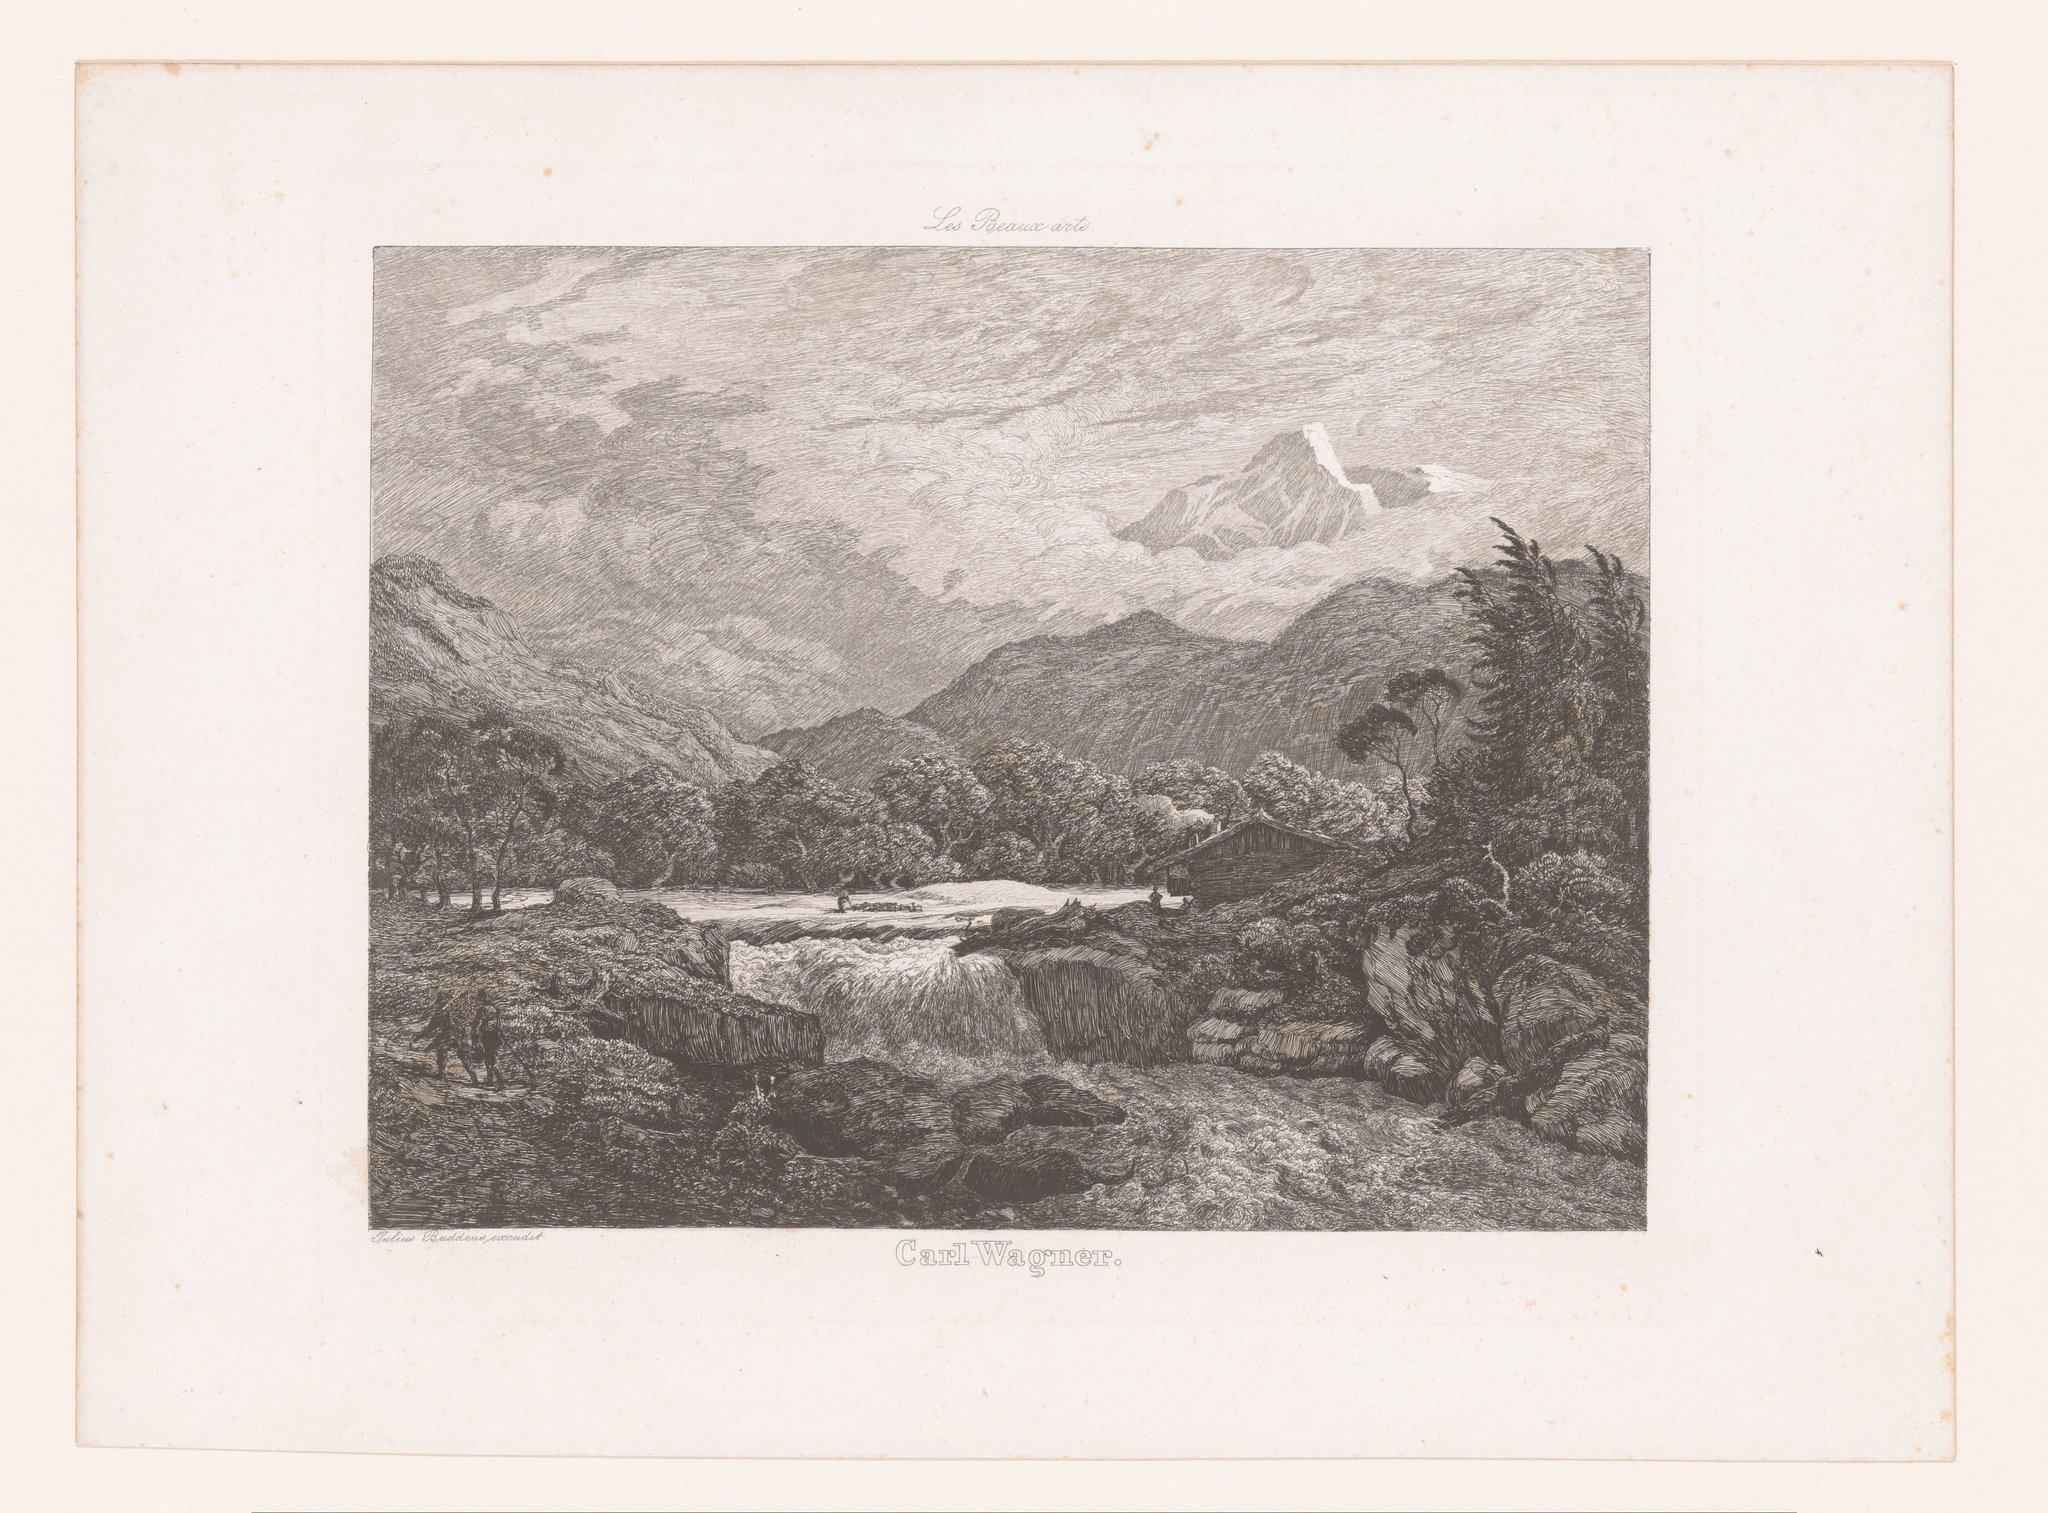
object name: print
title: Berglandschap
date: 1822-1873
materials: paper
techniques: etching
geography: germany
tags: landscapes with waters, waterscapes, seascapes (in the temperate zone), mountains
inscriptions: collector's mark: Lugt 2233